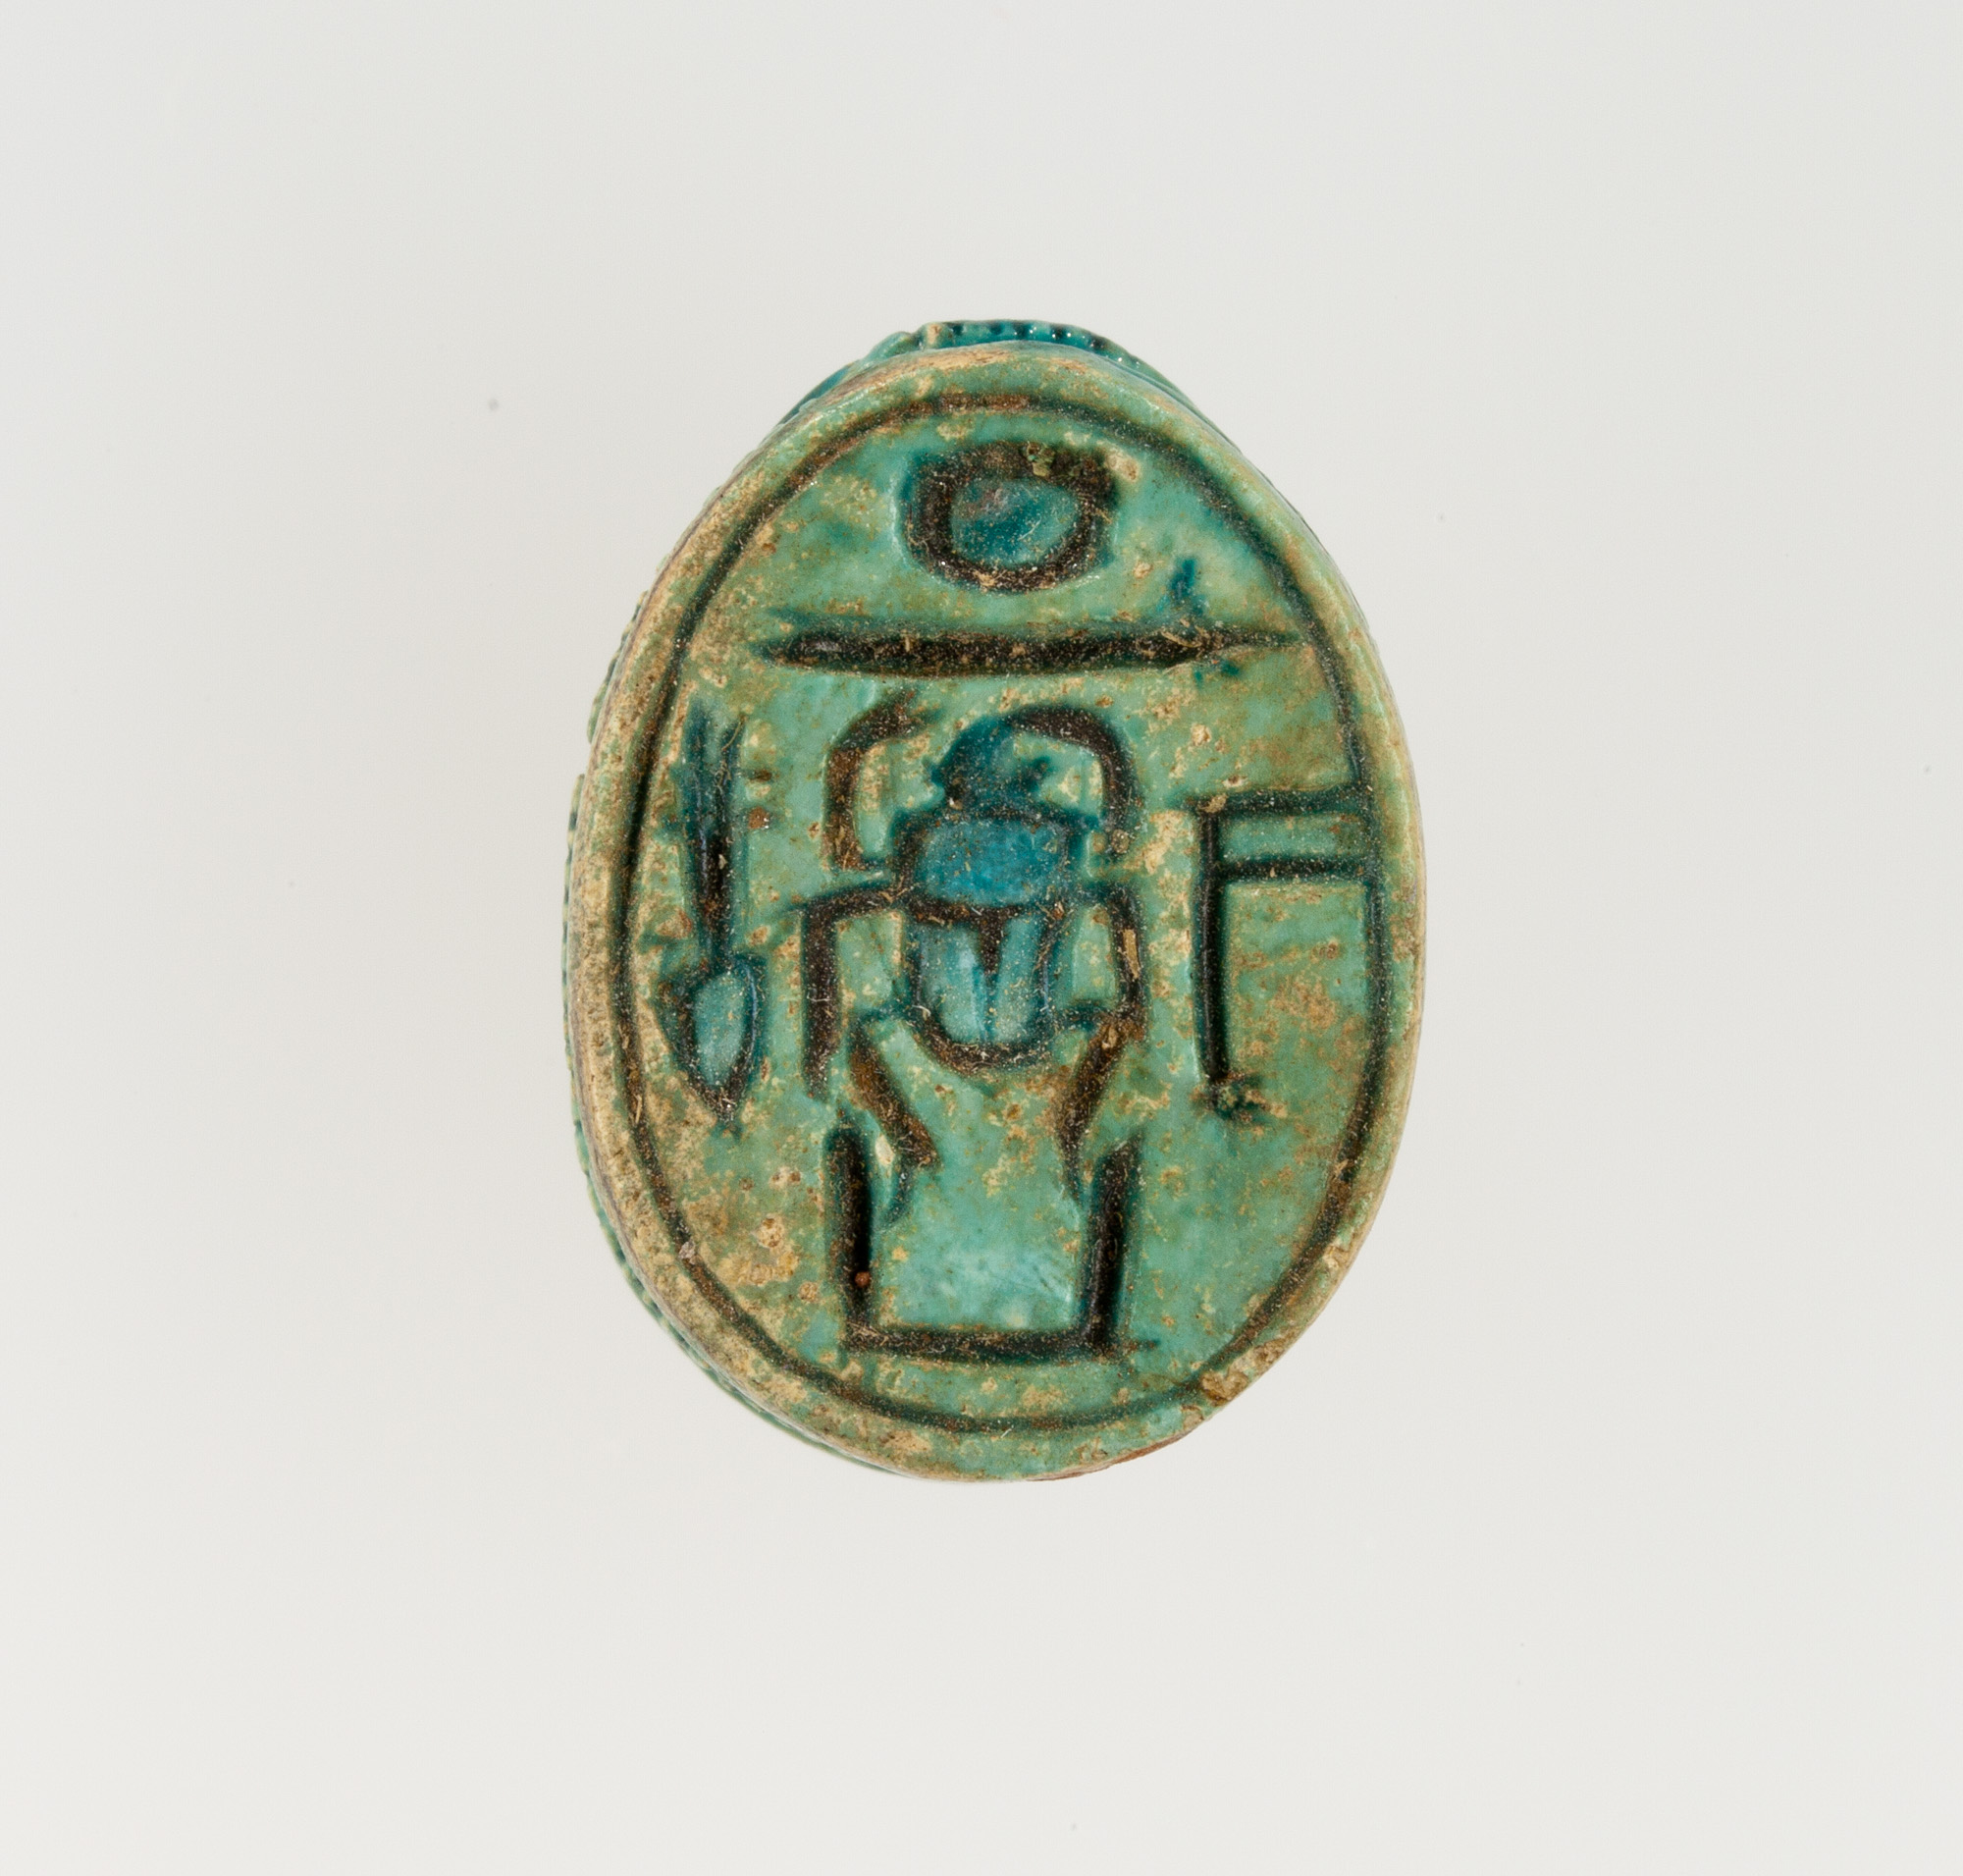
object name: scarab, thutmose i, aakheperkare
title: Scarab Inscribed with the Throne Name of Thutmose I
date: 1504-1492 BCE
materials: stone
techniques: glazing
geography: egypt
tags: hieroglyphs,scarabs